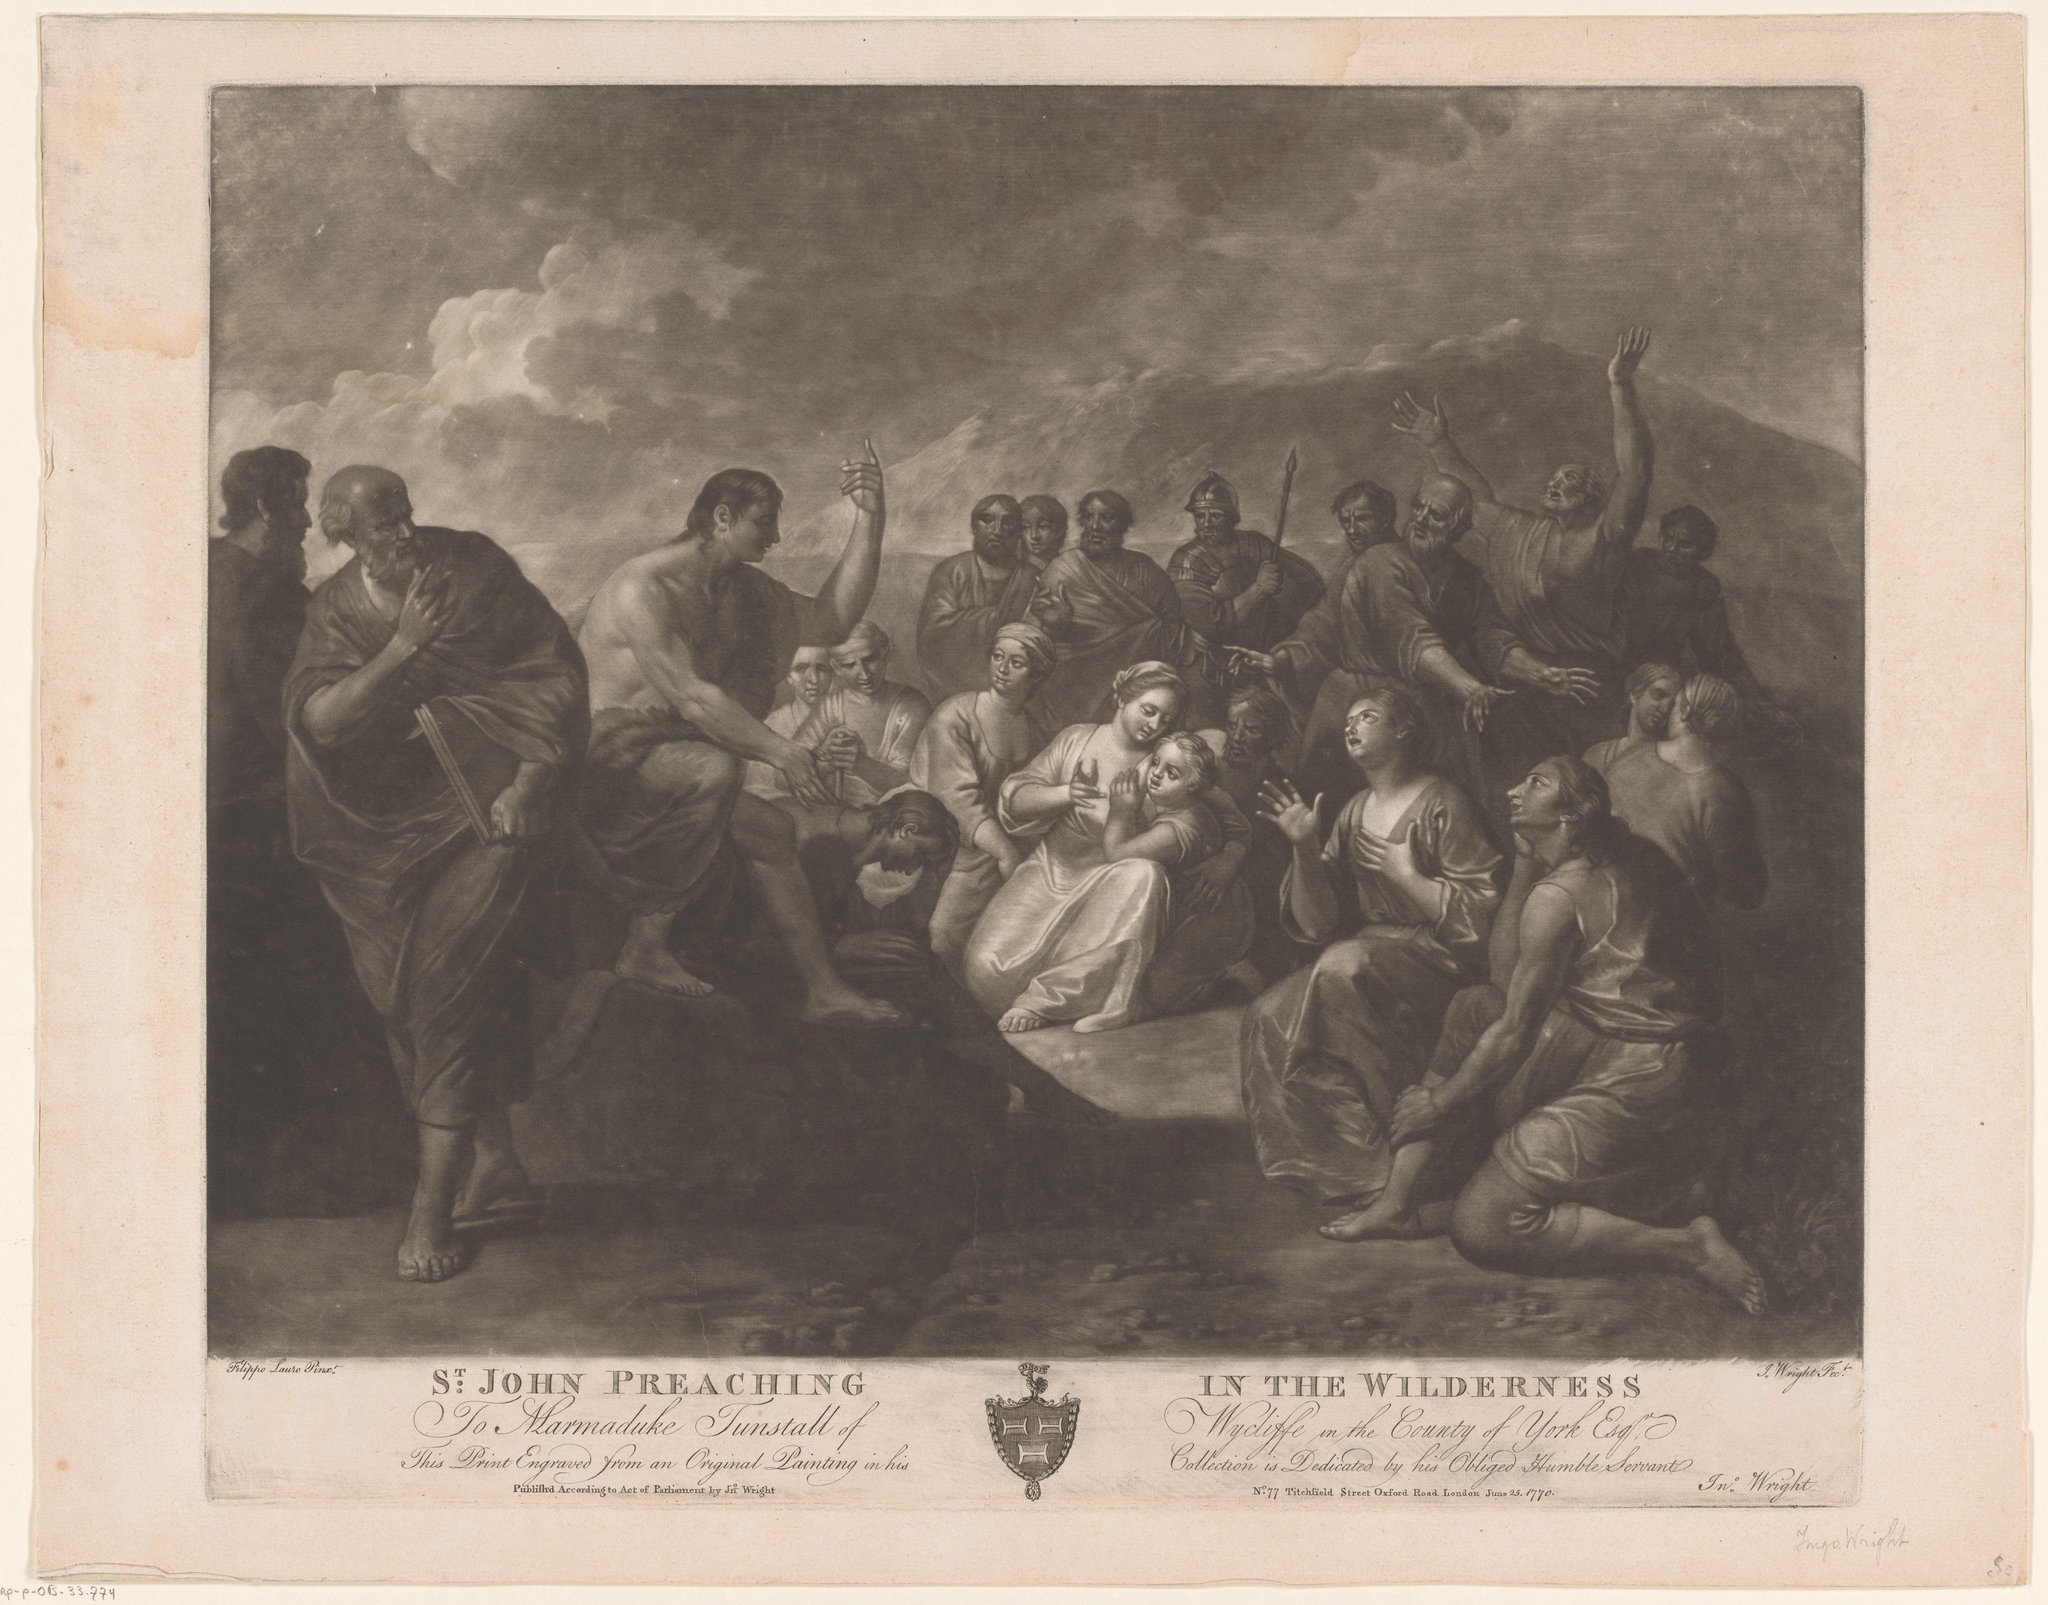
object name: print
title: St. John Preaching in the Wilderness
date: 1706-1770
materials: paper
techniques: mezzotint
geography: london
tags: john the baptist preaching (perhaps christ among the bystanders)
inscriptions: collector's mark: Lugt 240